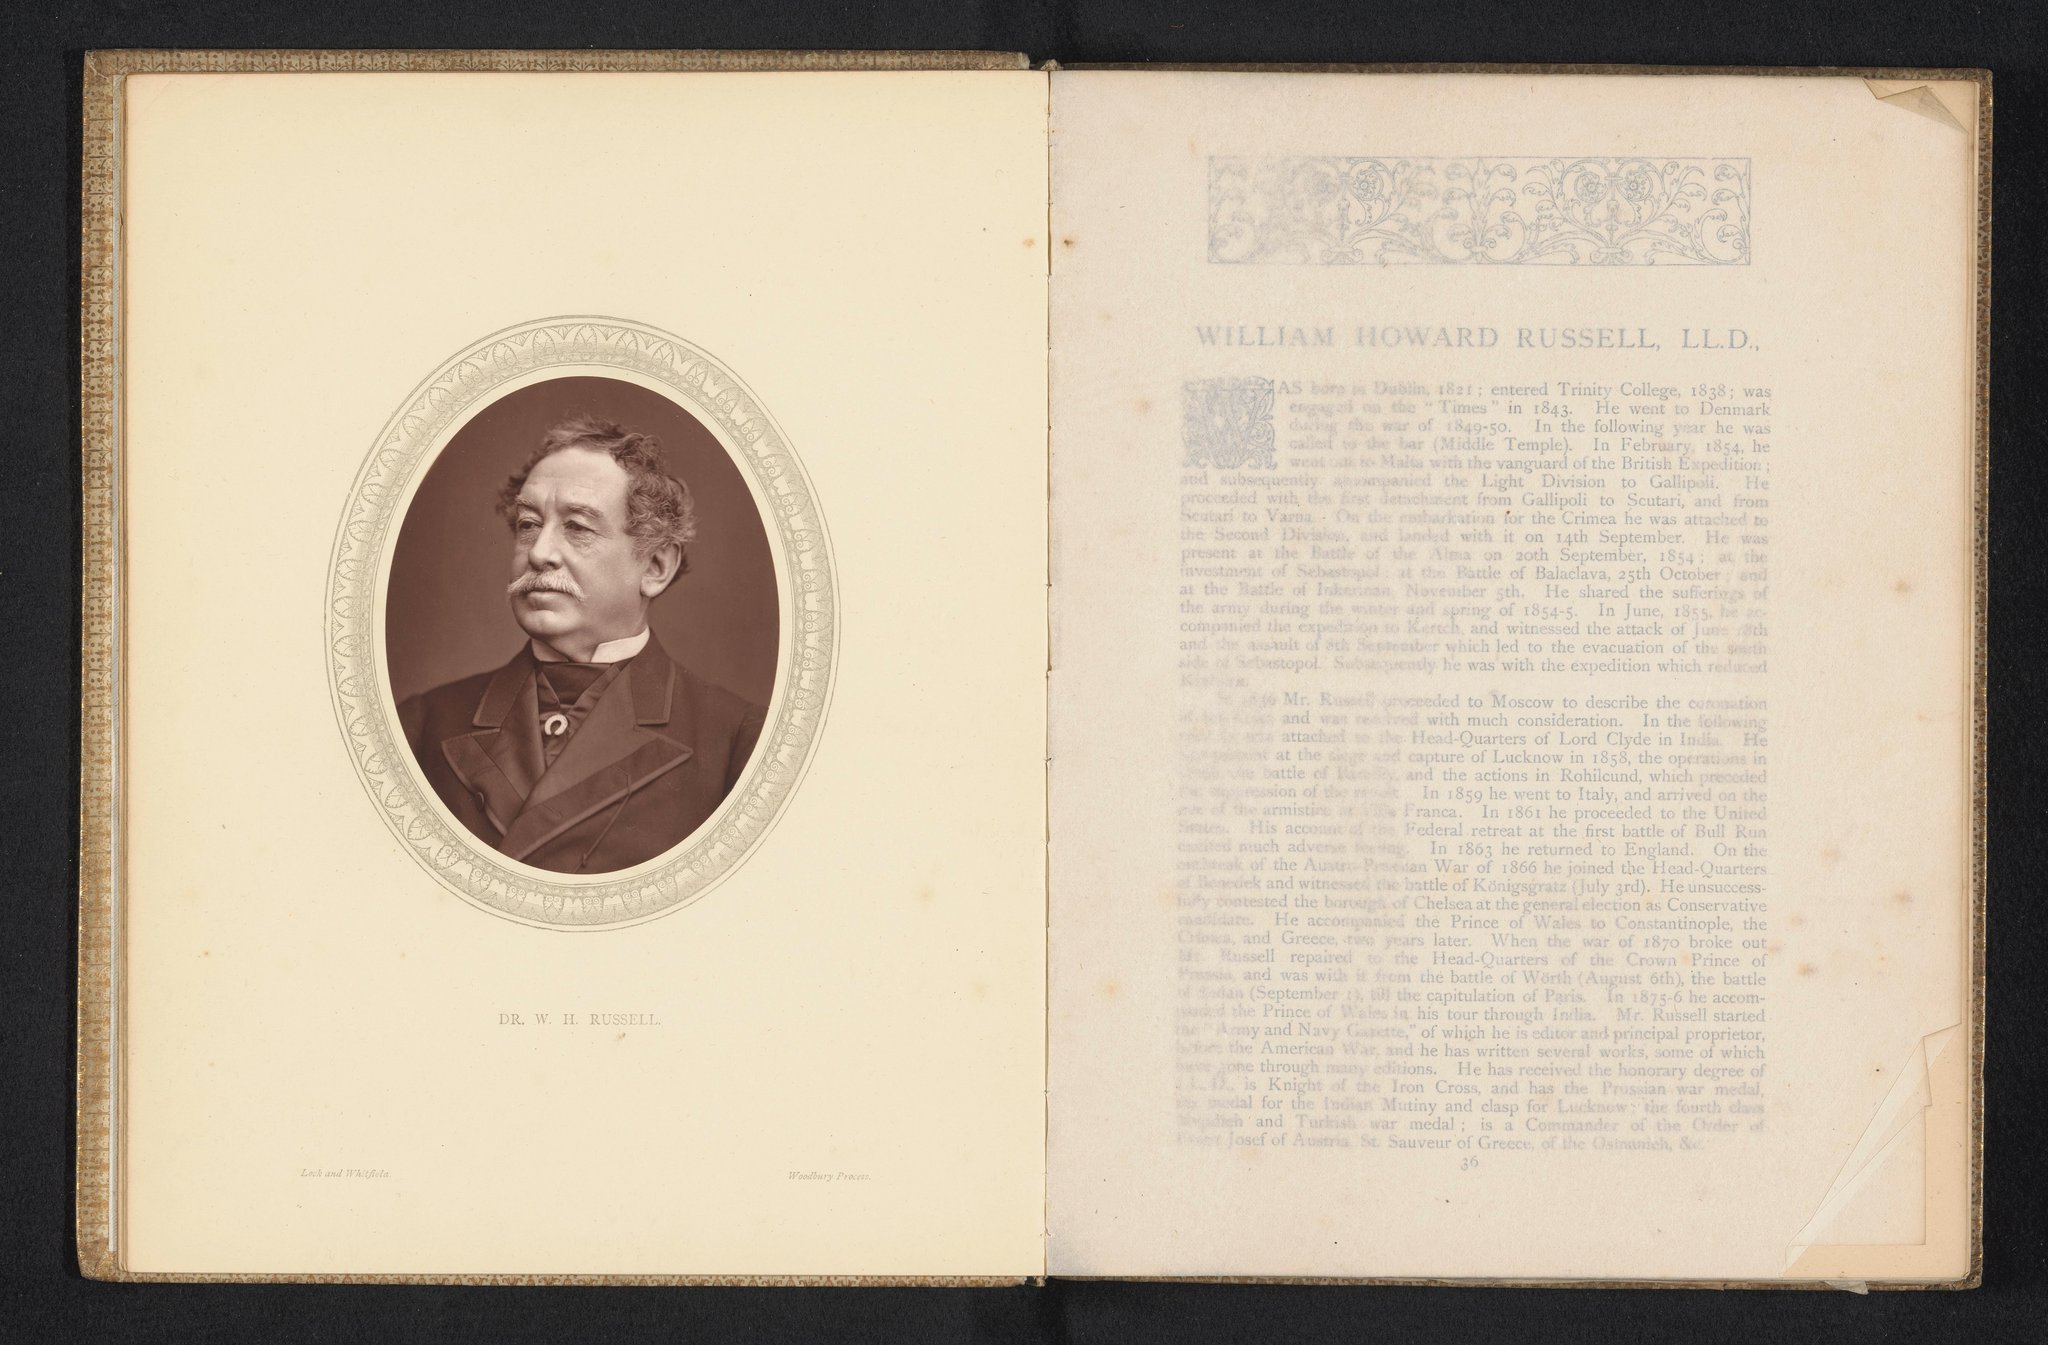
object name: photomechanical print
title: Dr. W.H. Russell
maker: Anonymous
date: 1871-1876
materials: paper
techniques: woodburytype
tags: journalist, reporter, historical persons (portraits and scenes from the life) (+ (full) bust portrait)